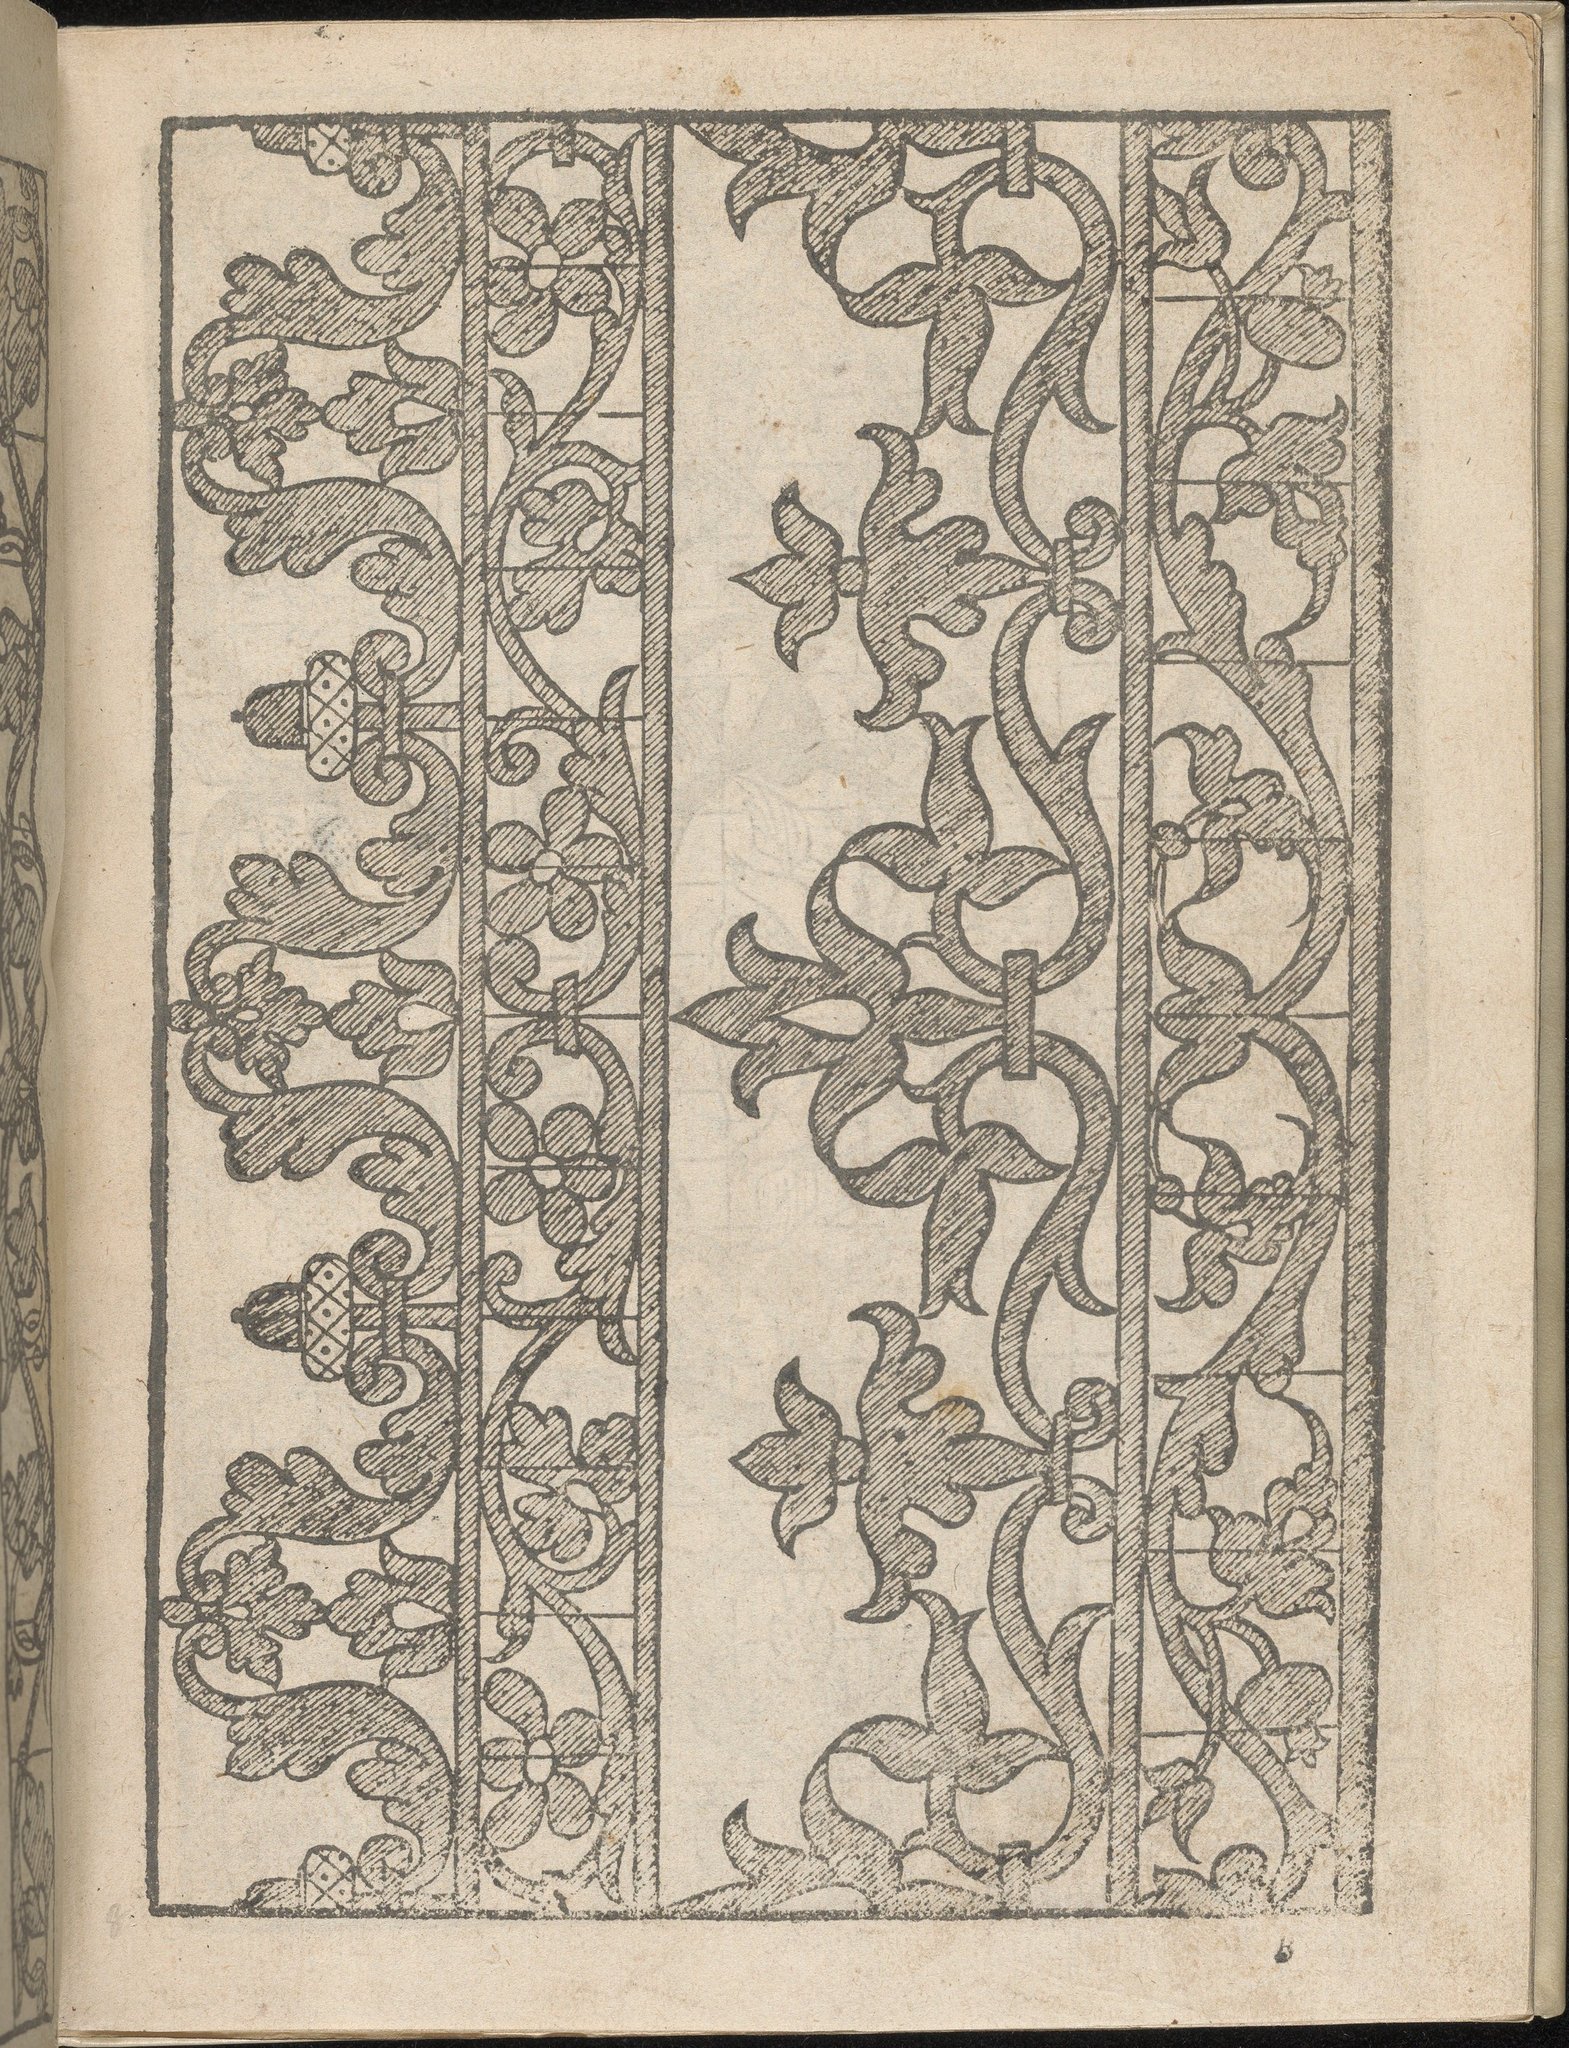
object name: book print ornament architecture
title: Lucidario di Recami, page 9 (recto)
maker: iseppo foresto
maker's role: designer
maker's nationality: italian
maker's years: 1520-1580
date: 1564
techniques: woodcut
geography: italy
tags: flowers,acorns,vines